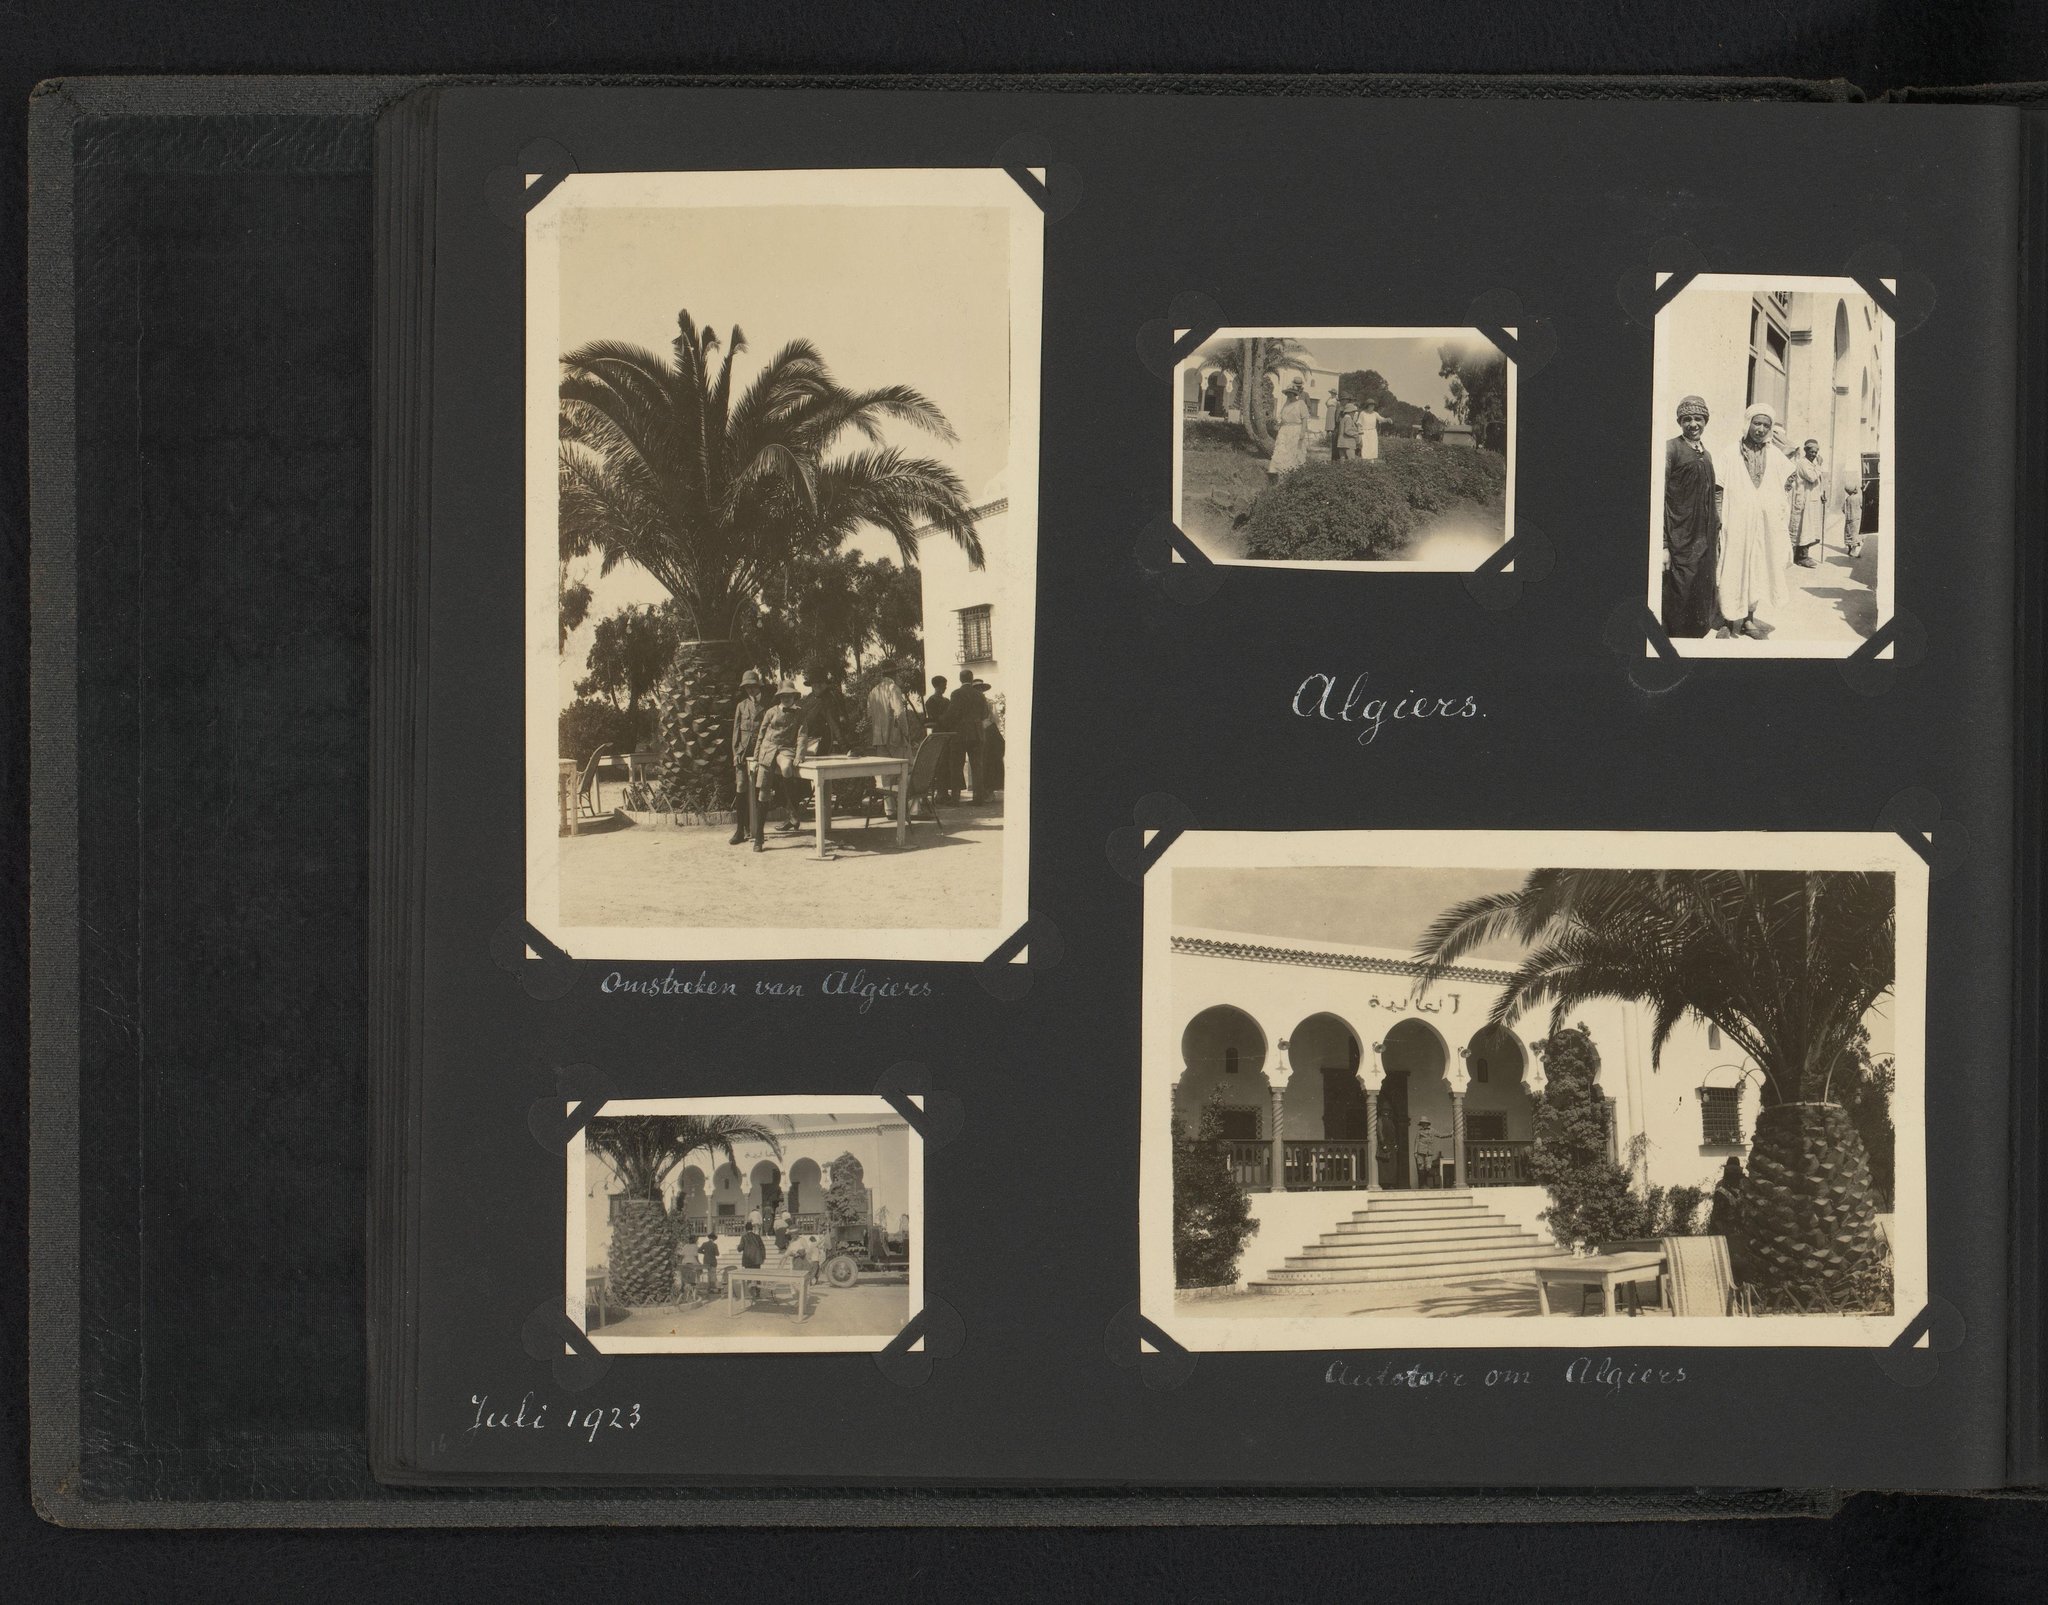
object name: photograph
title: Juli 1923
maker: hendrik herman van den berg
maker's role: amateurfotograaf, jurist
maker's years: 1875-1944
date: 1907-1923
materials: paper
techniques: gelatin silver print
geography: algiers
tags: the hague, caroline louise van den berg-van den berg, carel frederik van den berg (cay), frank willem van den berg (1912-1998), the family travelling, on holiday, temple, shrine ~ islam, mohammedanism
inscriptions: inscription: ‘Autotoer om Algiers’, inscription: ‘Omstreken van Algiers’, inscription: ‘Algiers’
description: Deze foto's maken deel uit van een album.